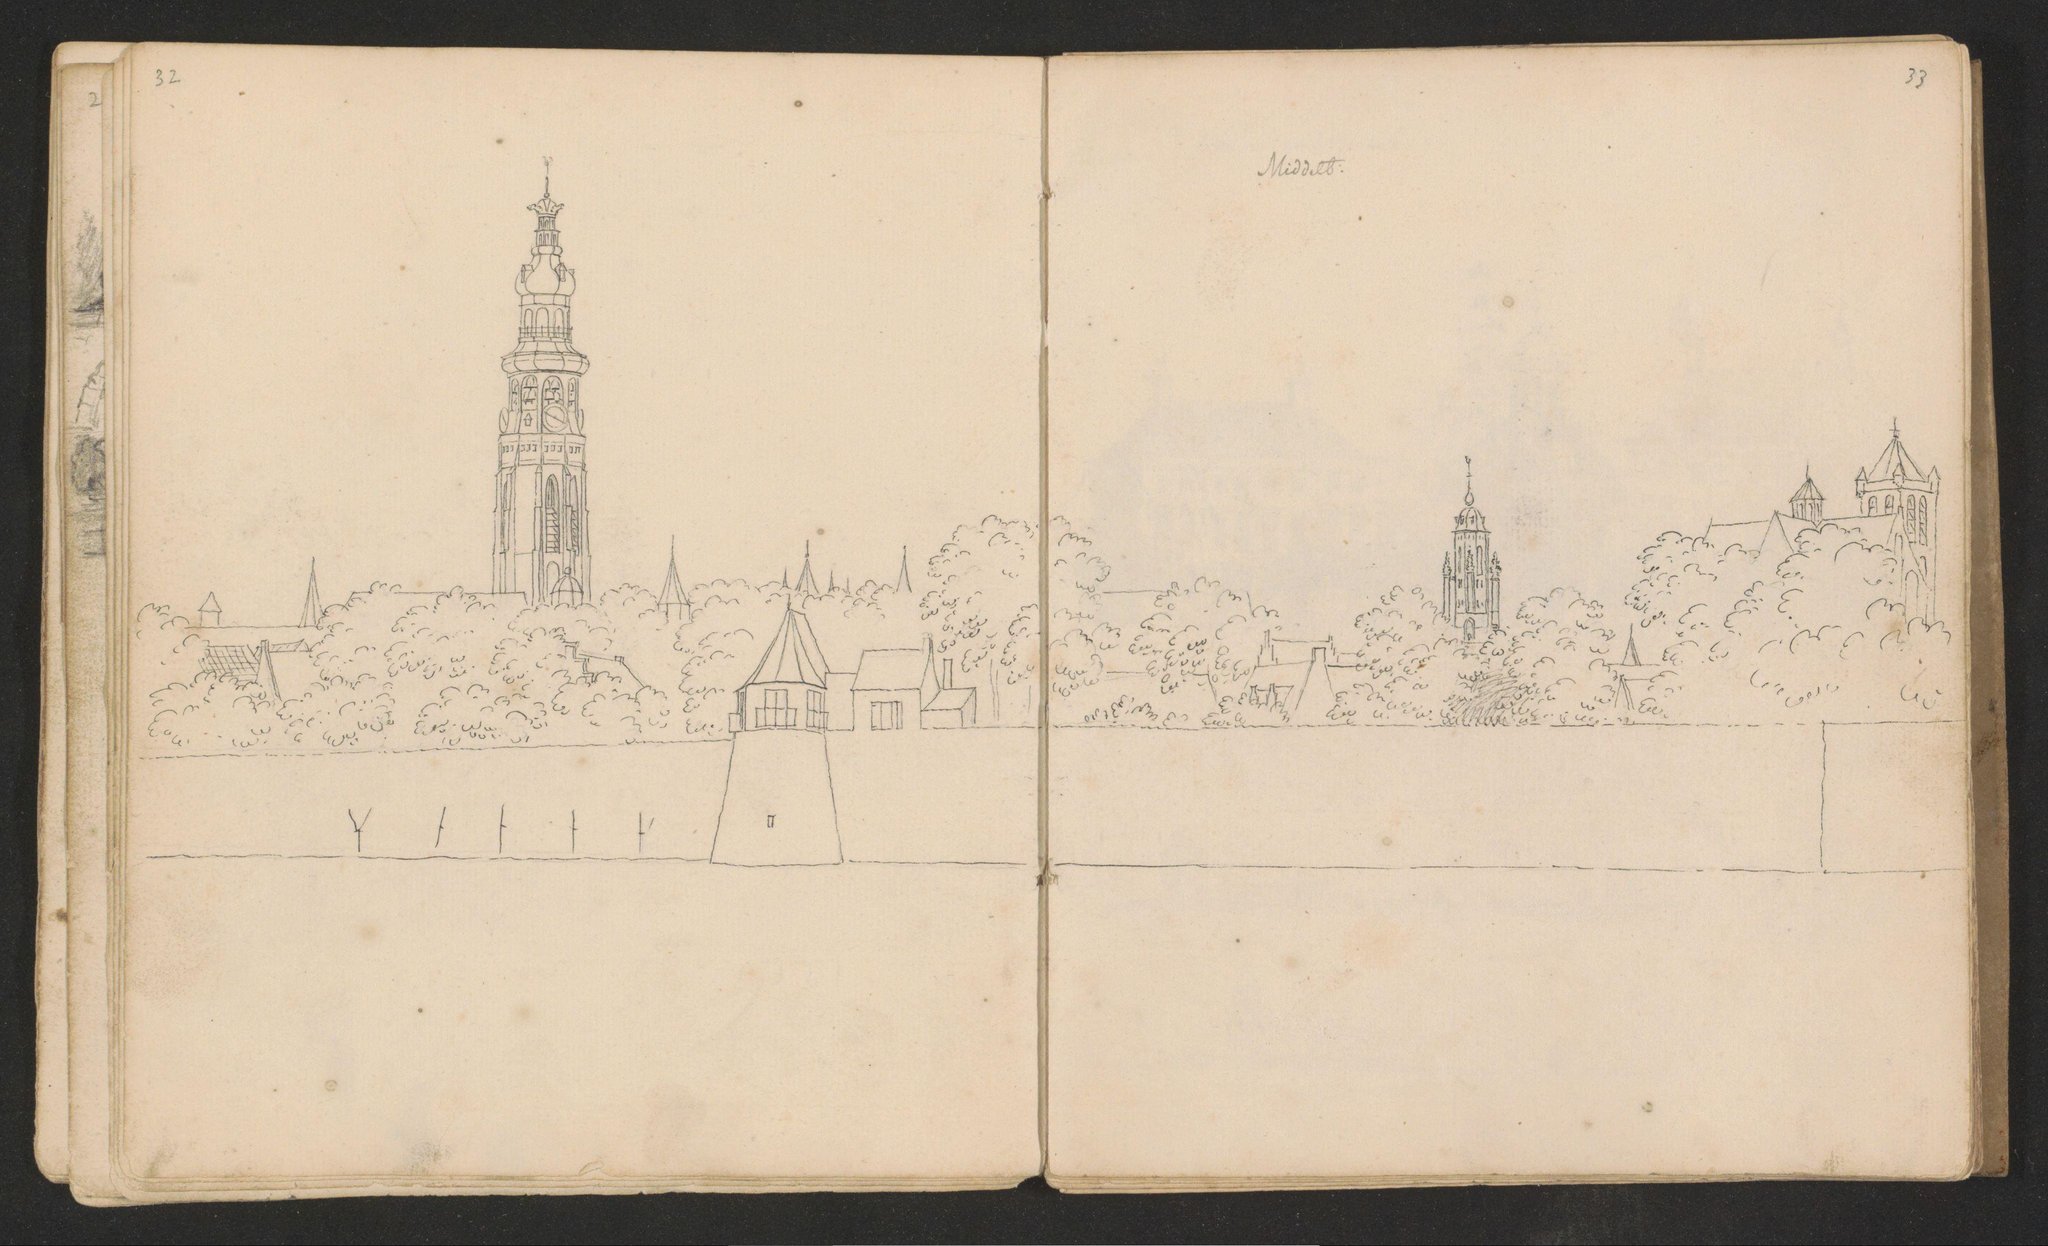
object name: sketchbook leaf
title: Gezicht op Middelburg met de Abdijtoren en het stadhuis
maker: cornelis pronk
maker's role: draughtsman, painter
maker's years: 1691-1759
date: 1728-1732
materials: ink, paper, pencil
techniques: pen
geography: middelburg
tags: city-view, and landscape with man-made constructions, middelburg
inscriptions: annotation: ‘Middelb.’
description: Bladzijde 32 en 33 uit een schetsboek met 96 bladzijden.